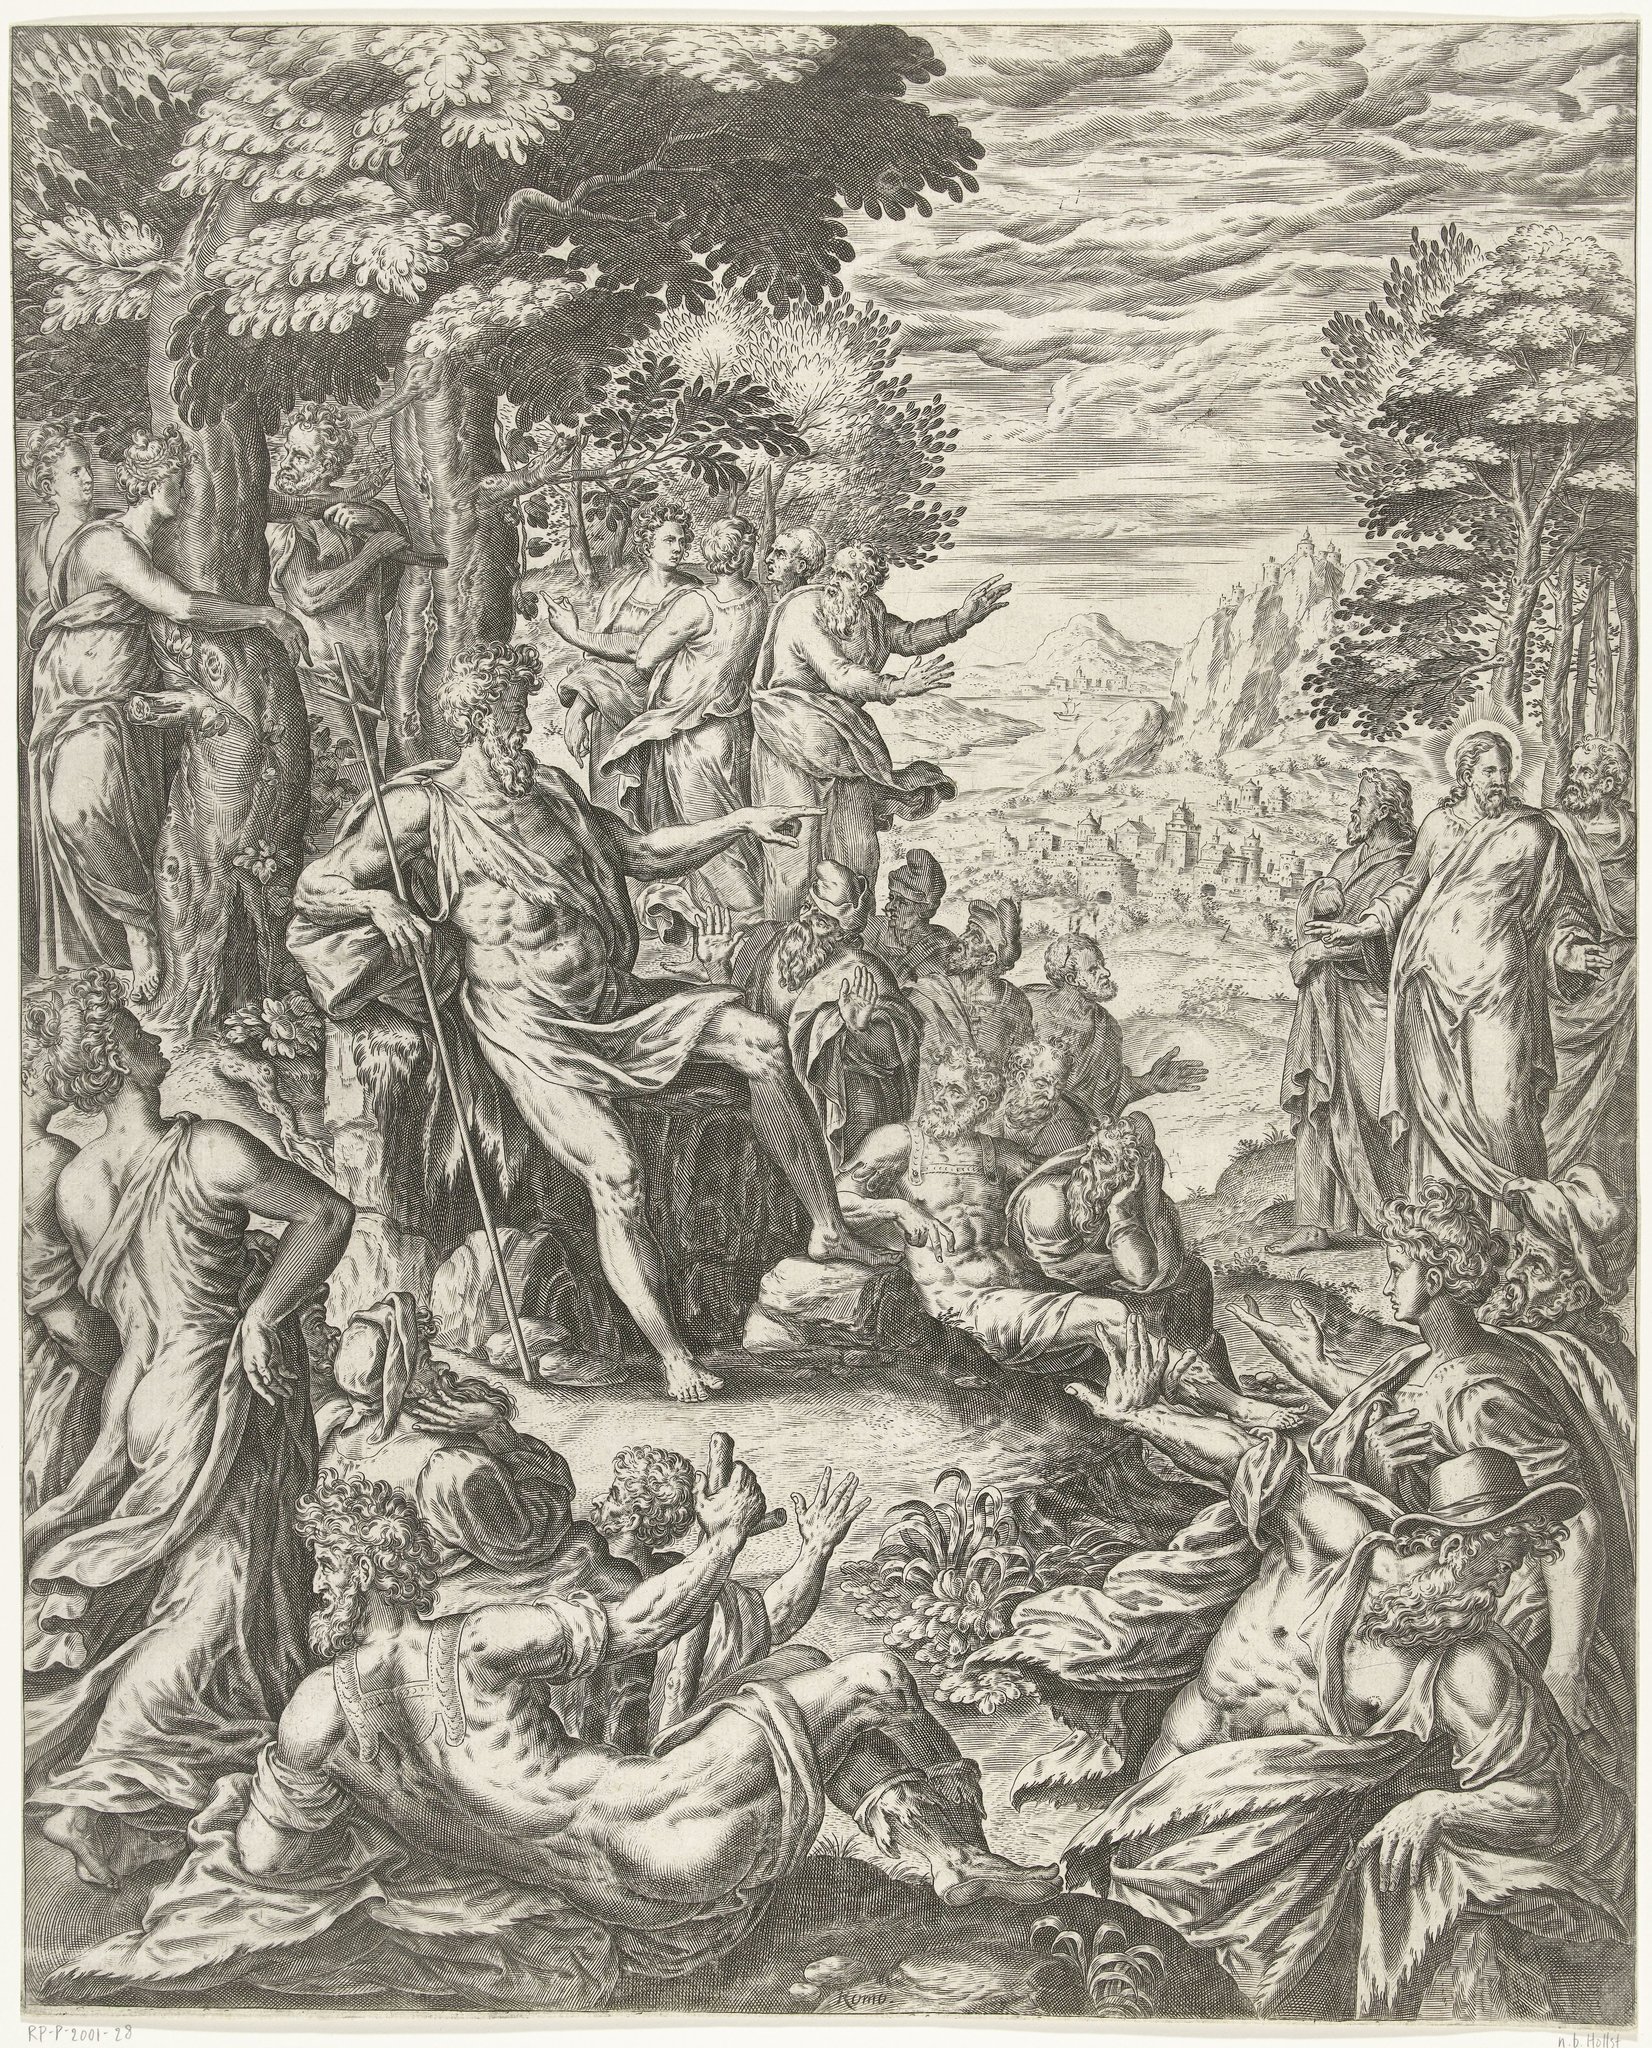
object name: print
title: Johannes de Doper predikt tot de menigte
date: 1575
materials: paper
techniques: engraving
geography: antwerp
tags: john the baptist identifies christ as the lamb of god ('ecce agnus dei') (john 1:29, 1:36)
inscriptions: collector's mark: Lugt 2228, collector's mark: Lugt 2760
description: Centraal zit Johannes de Doper op een rots. In zijn handen het rieten kruis. Rondom hem staat een menigte te luisteren. Christus is juist aangekomen en Johannes de Doper wijst naar hem en spreekt de woorden: 'zie het lam Gods' (Joh. 1:36).